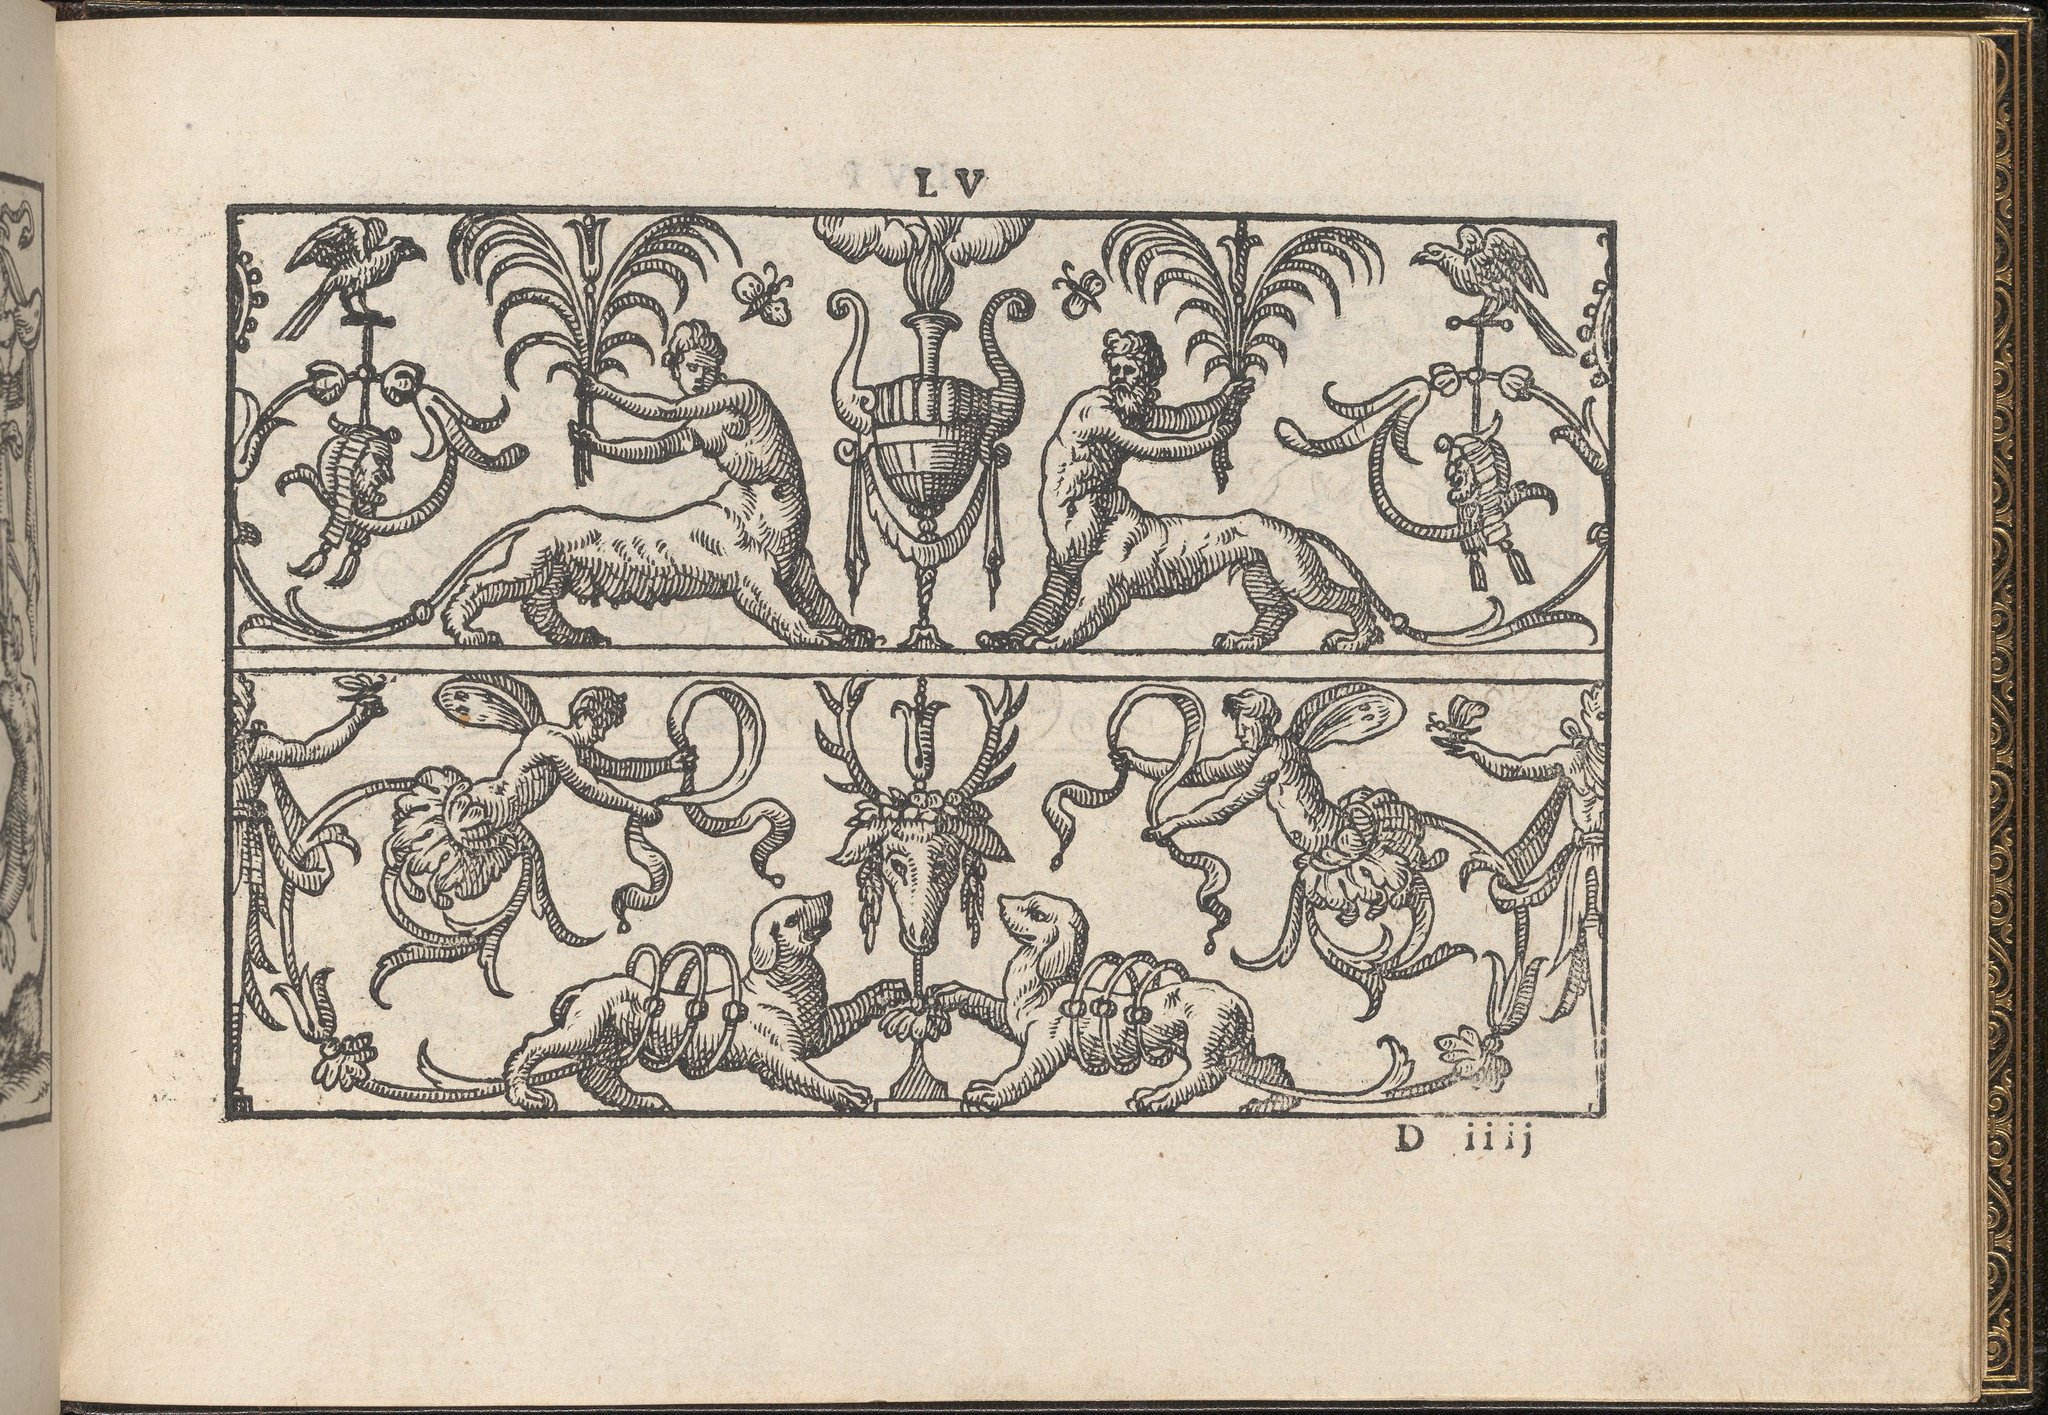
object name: book print ornament architecture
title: La Vera Perfettione del Disegno di varie sorti di recami, page 28 (recto)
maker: giovanni ostaus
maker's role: publisher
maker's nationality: italian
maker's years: 1507-1607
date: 1567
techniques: woodcut